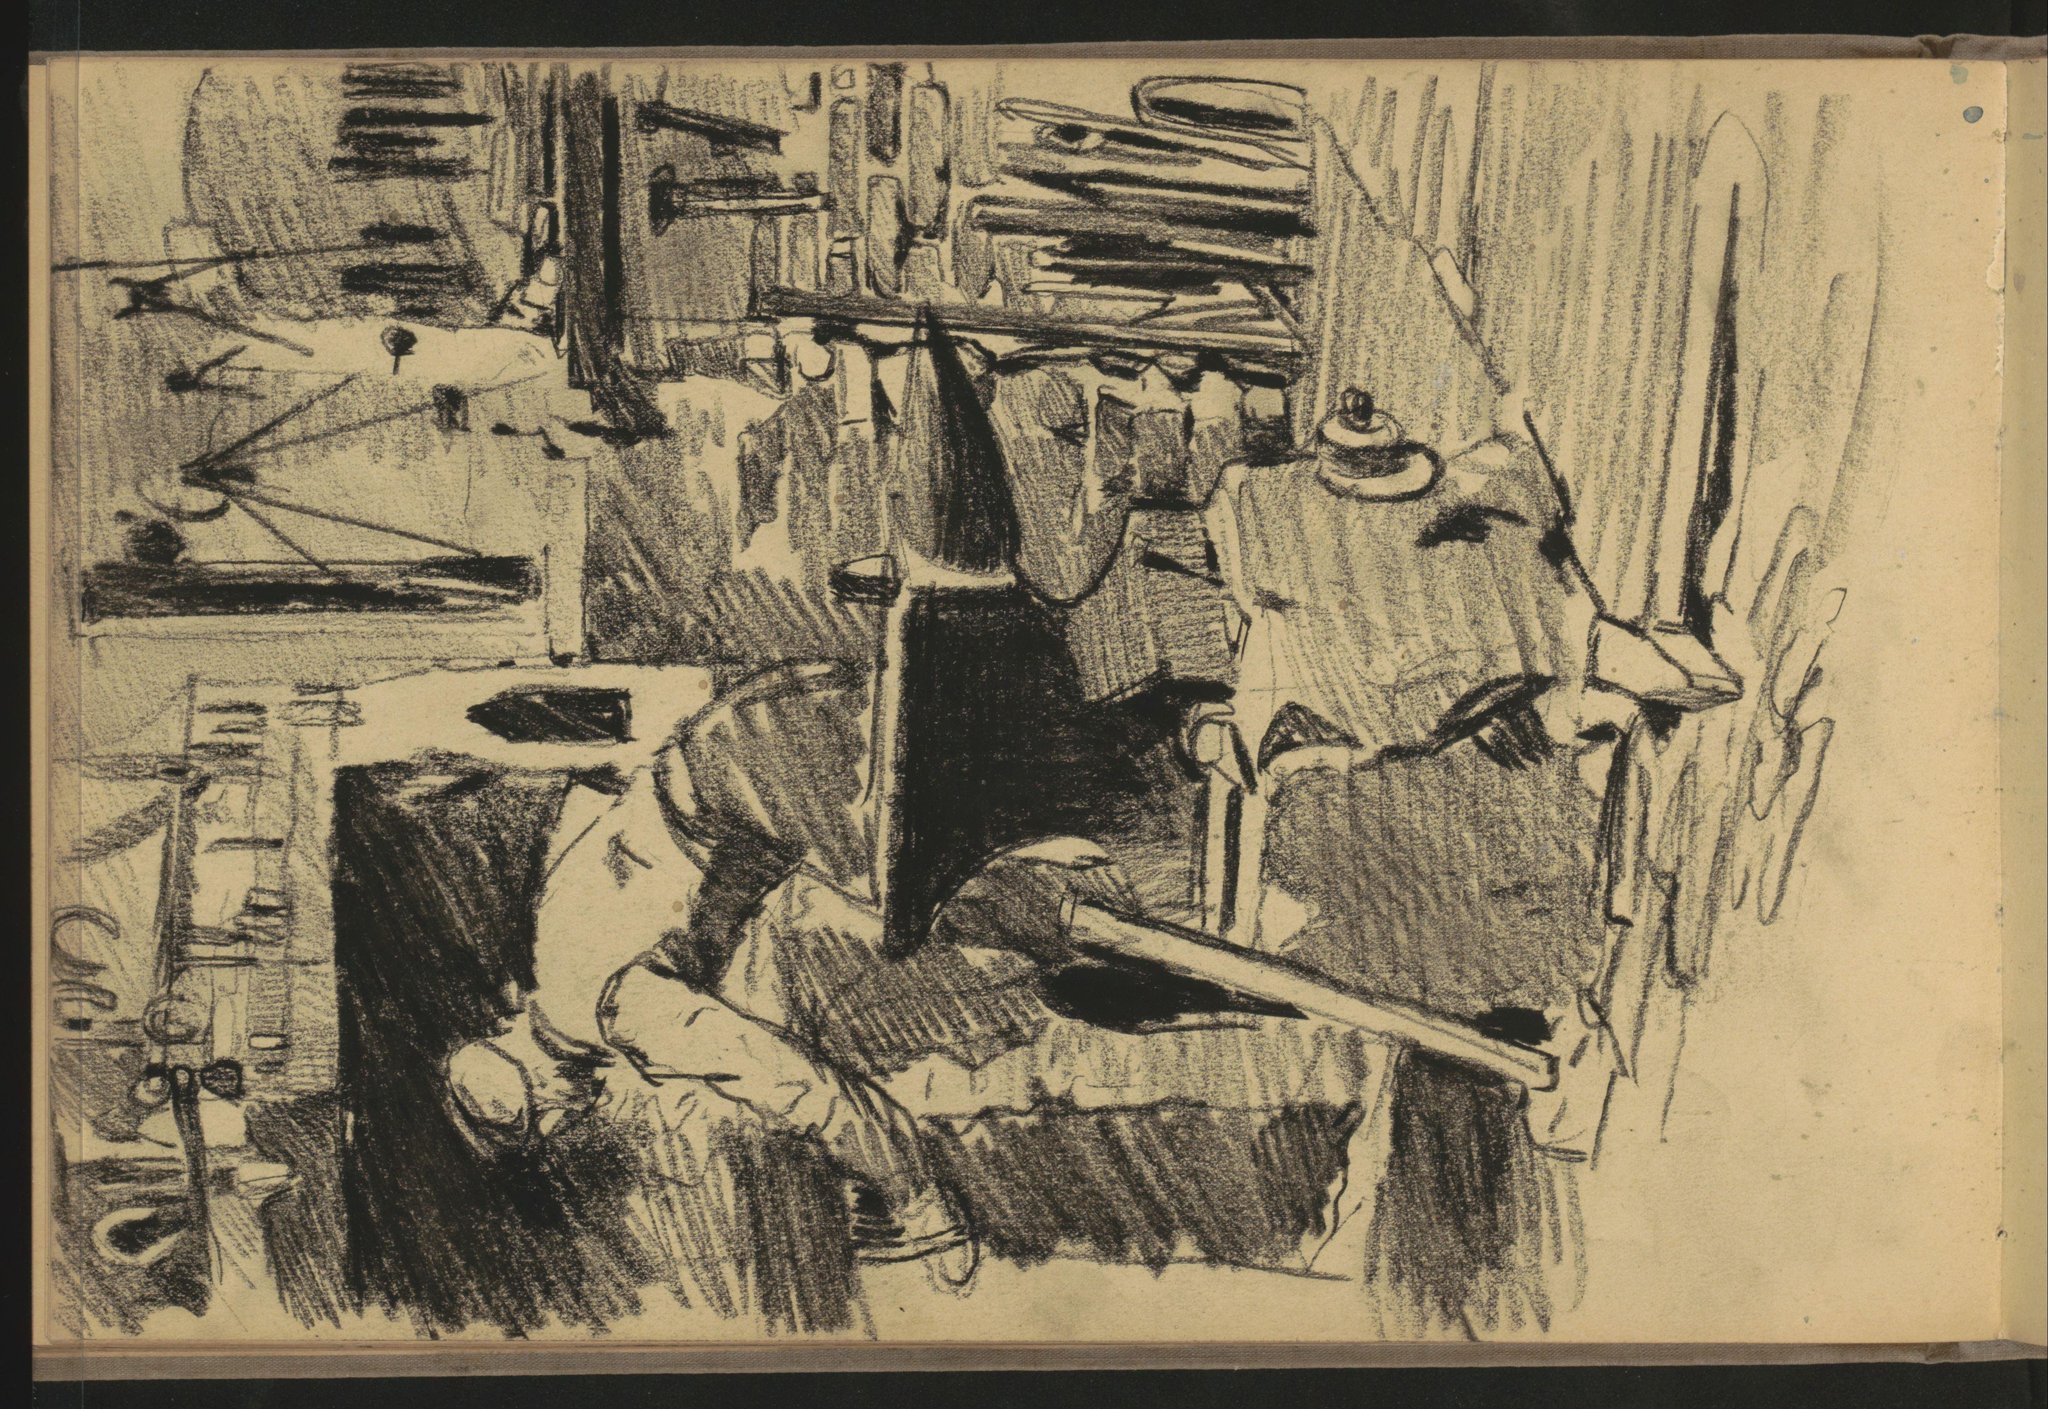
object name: sketchbook leaf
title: Smidse met vuur (Jan)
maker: willem witsen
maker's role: draughtsman, painter, print maker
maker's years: 1860-1923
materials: chalk, paper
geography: wijk bij duurstede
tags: smith, blacksmith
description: Voorstudie voor de ets 'Smidse met vuur (Jan)', ca. 1908.